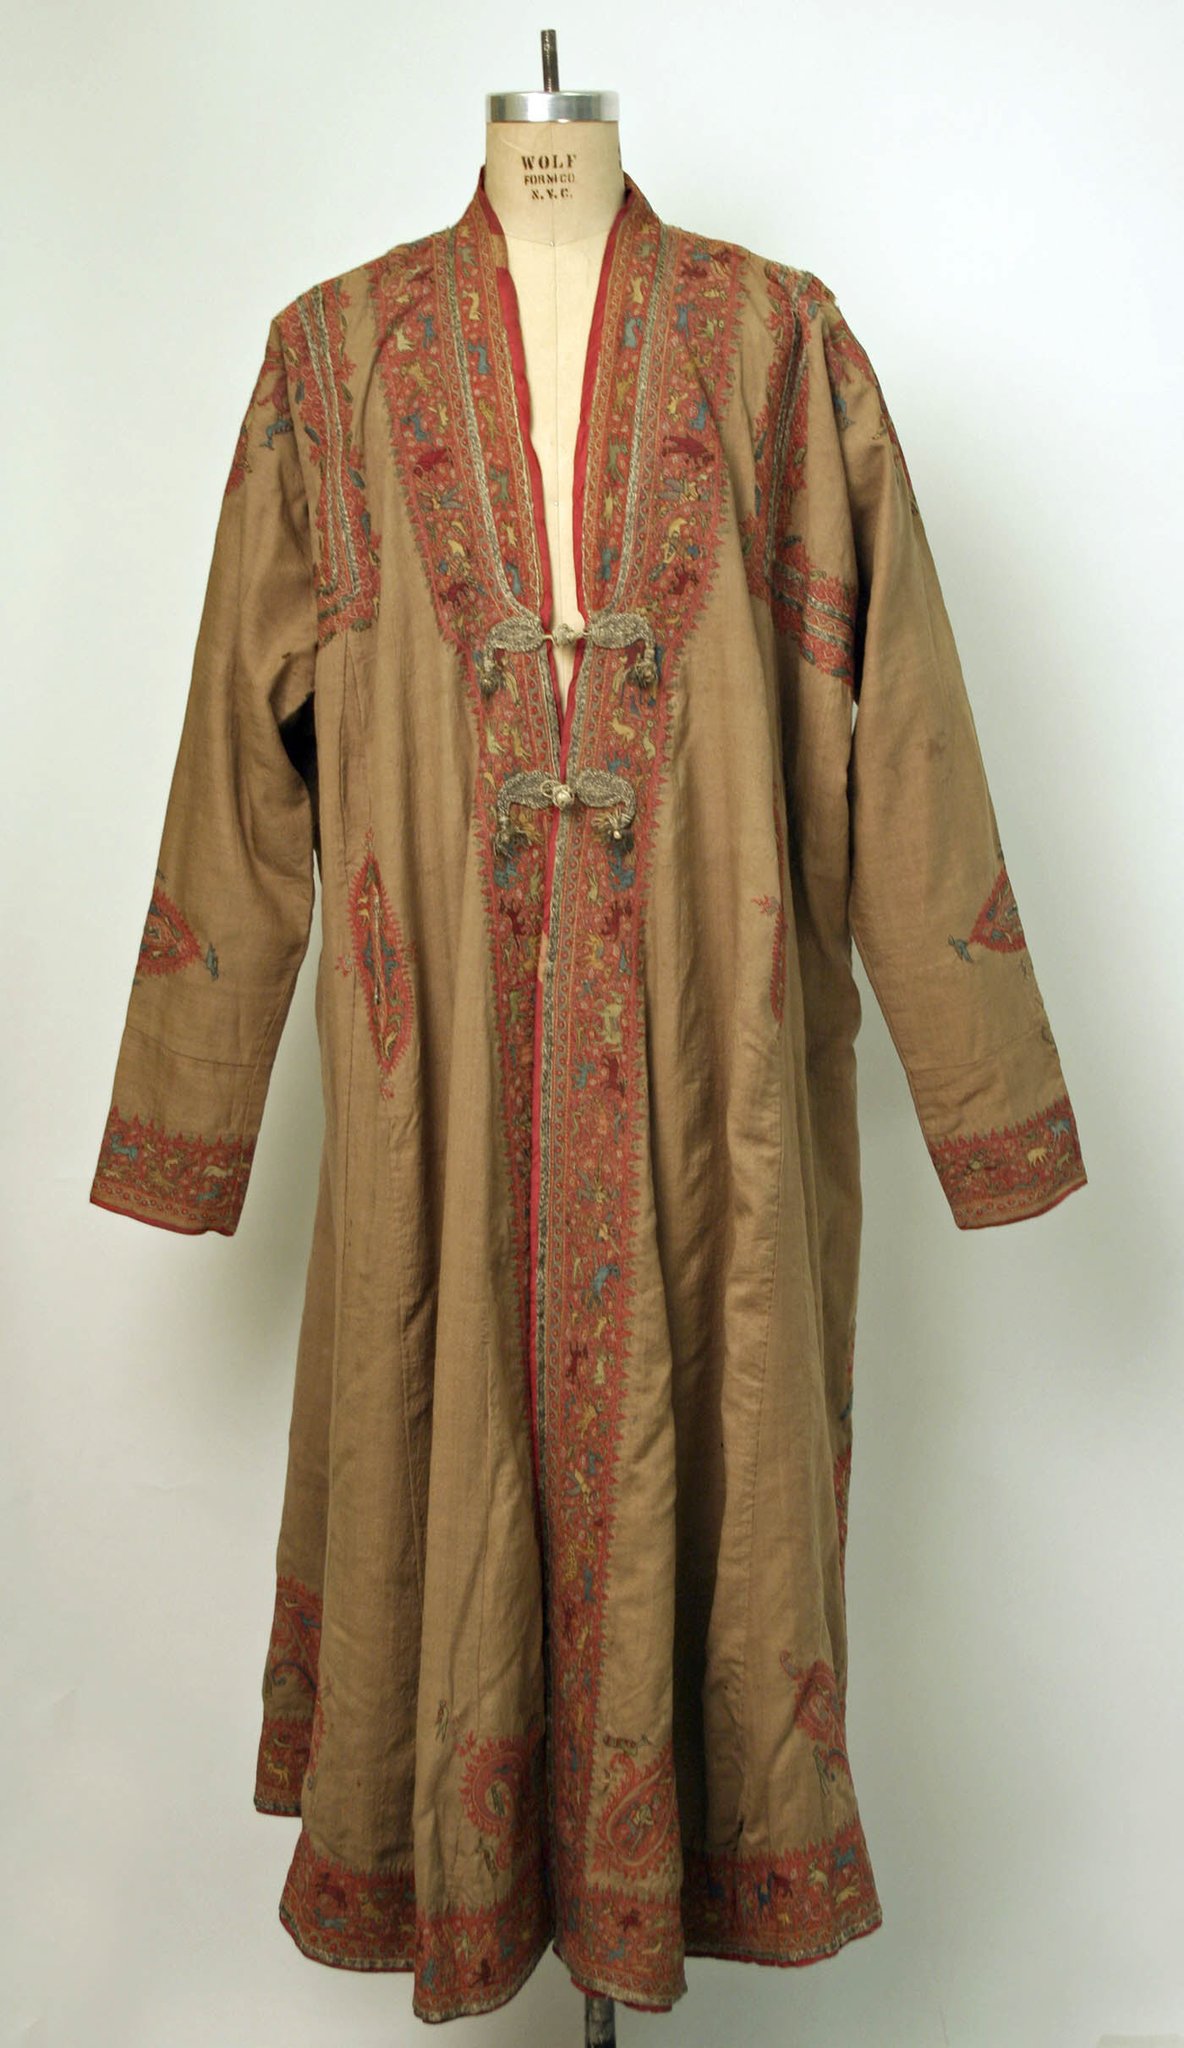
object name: coat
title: Choga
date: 1767-1833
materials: silk, wool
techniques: embroidery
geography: india